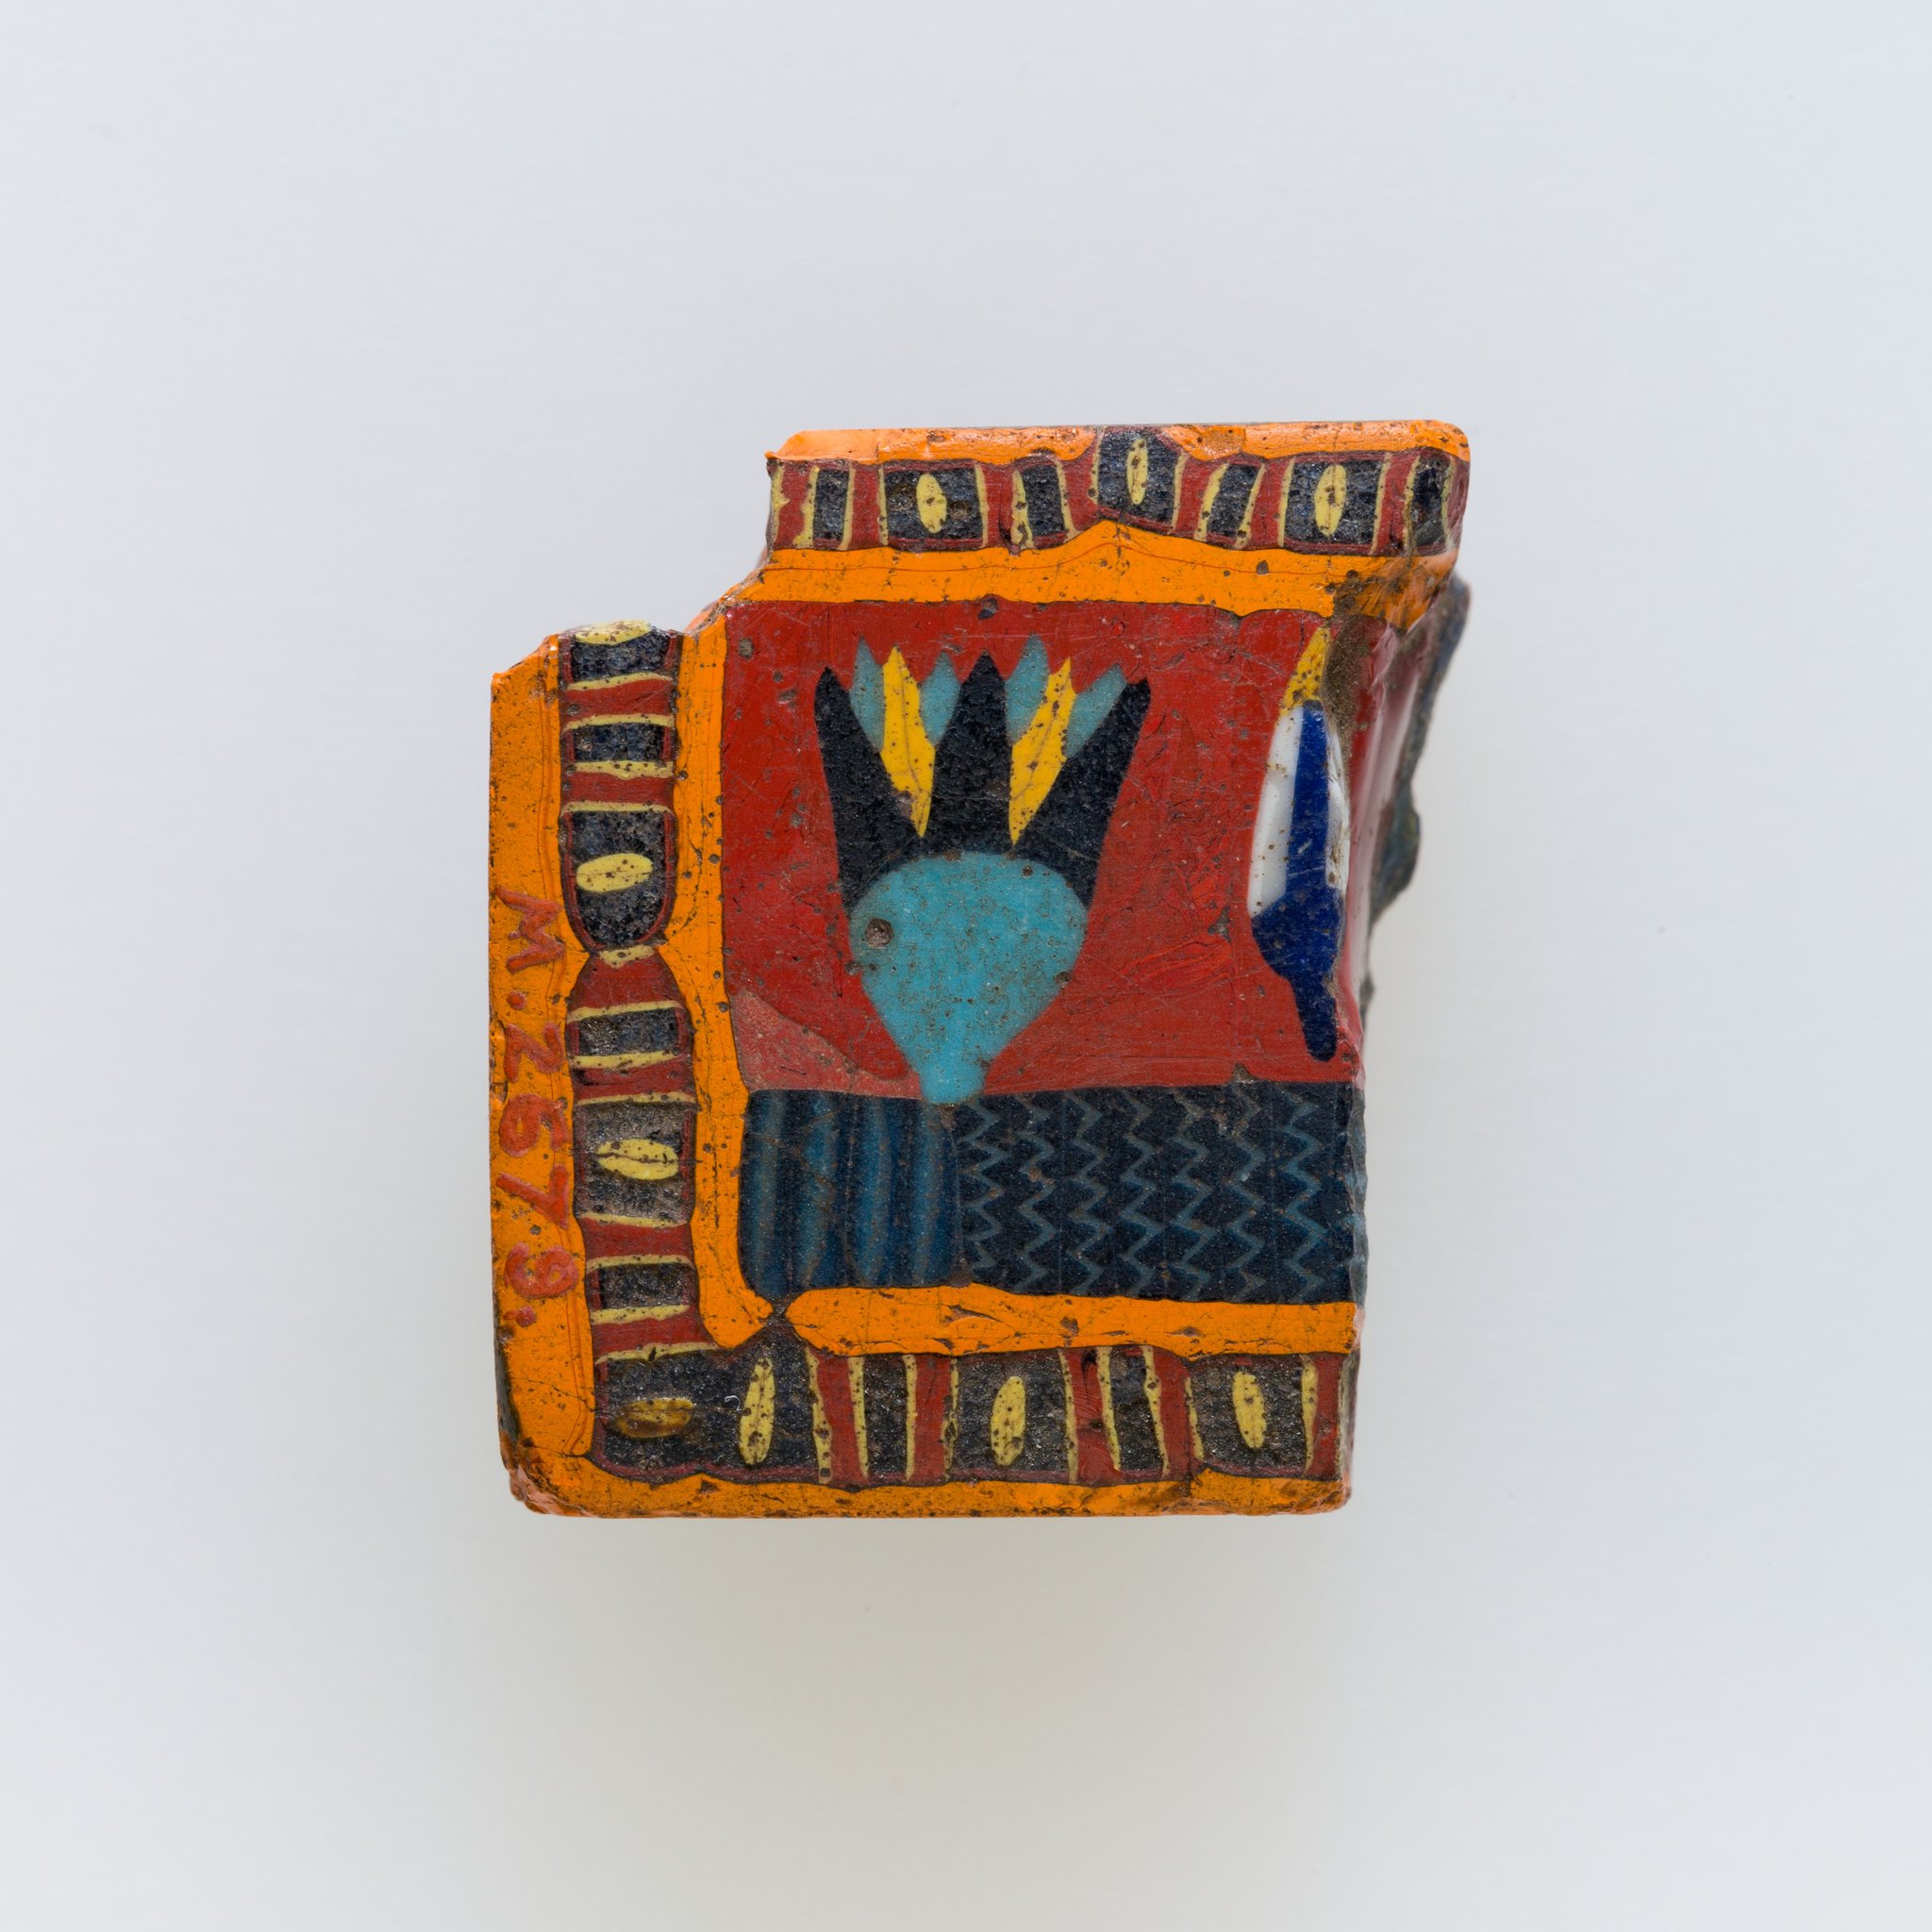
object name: inlay fragment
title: Inlay fragment, with lotus in a pool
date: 100 BCE-100 CE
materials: glass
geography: egypt